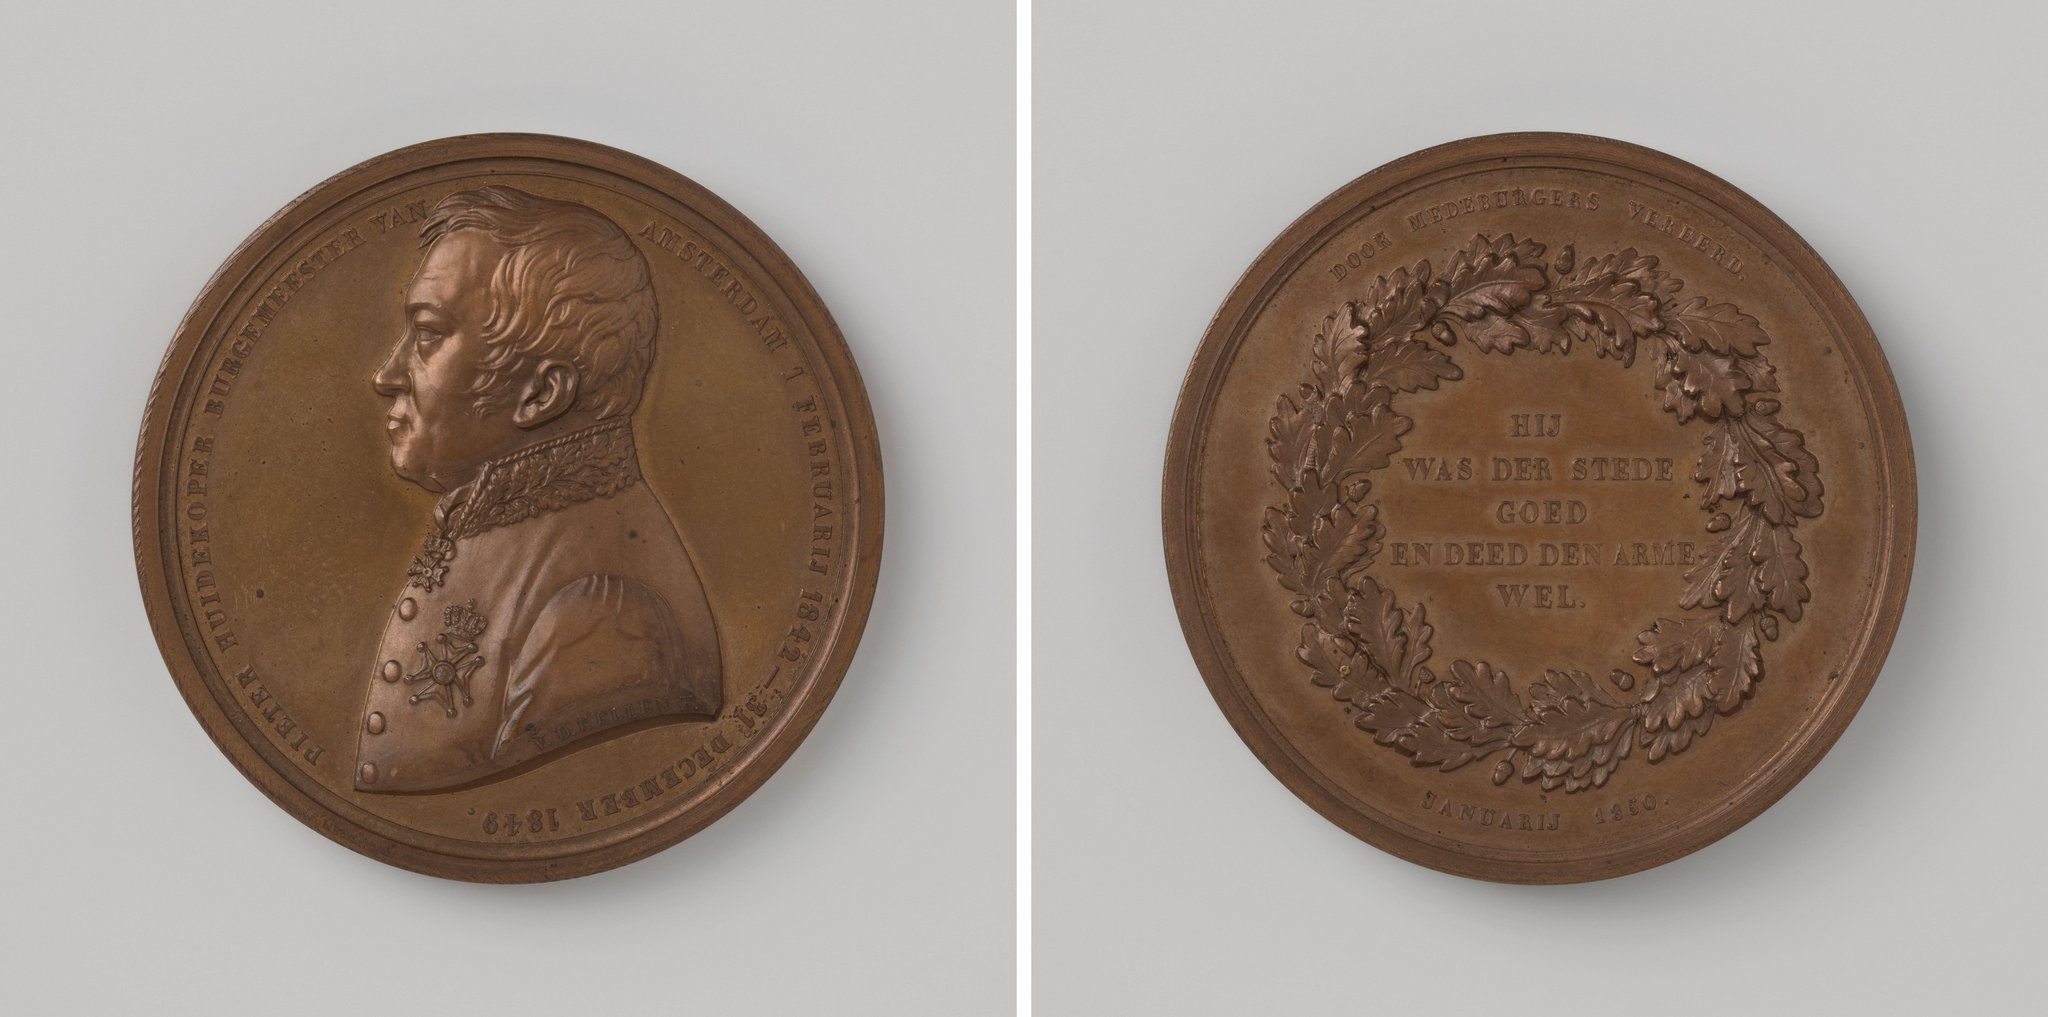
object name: history medal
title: Afscheid van Pieter Huidekoper als burgemeester van Amsterdam 1850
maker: david van der kellen (1804-1879)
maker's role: die cutter, draughtsman, print maker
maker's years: 1804-1879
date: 1850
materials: bronze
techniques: striking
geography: utrecht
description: Bronzen penning, op de voorzijde het geuniformeerde borstbeeld van Huidekoper naar links met omschrift, op de keerzijde vier regels tekst binnen een eikenkrans, met onder en boven omschrift.